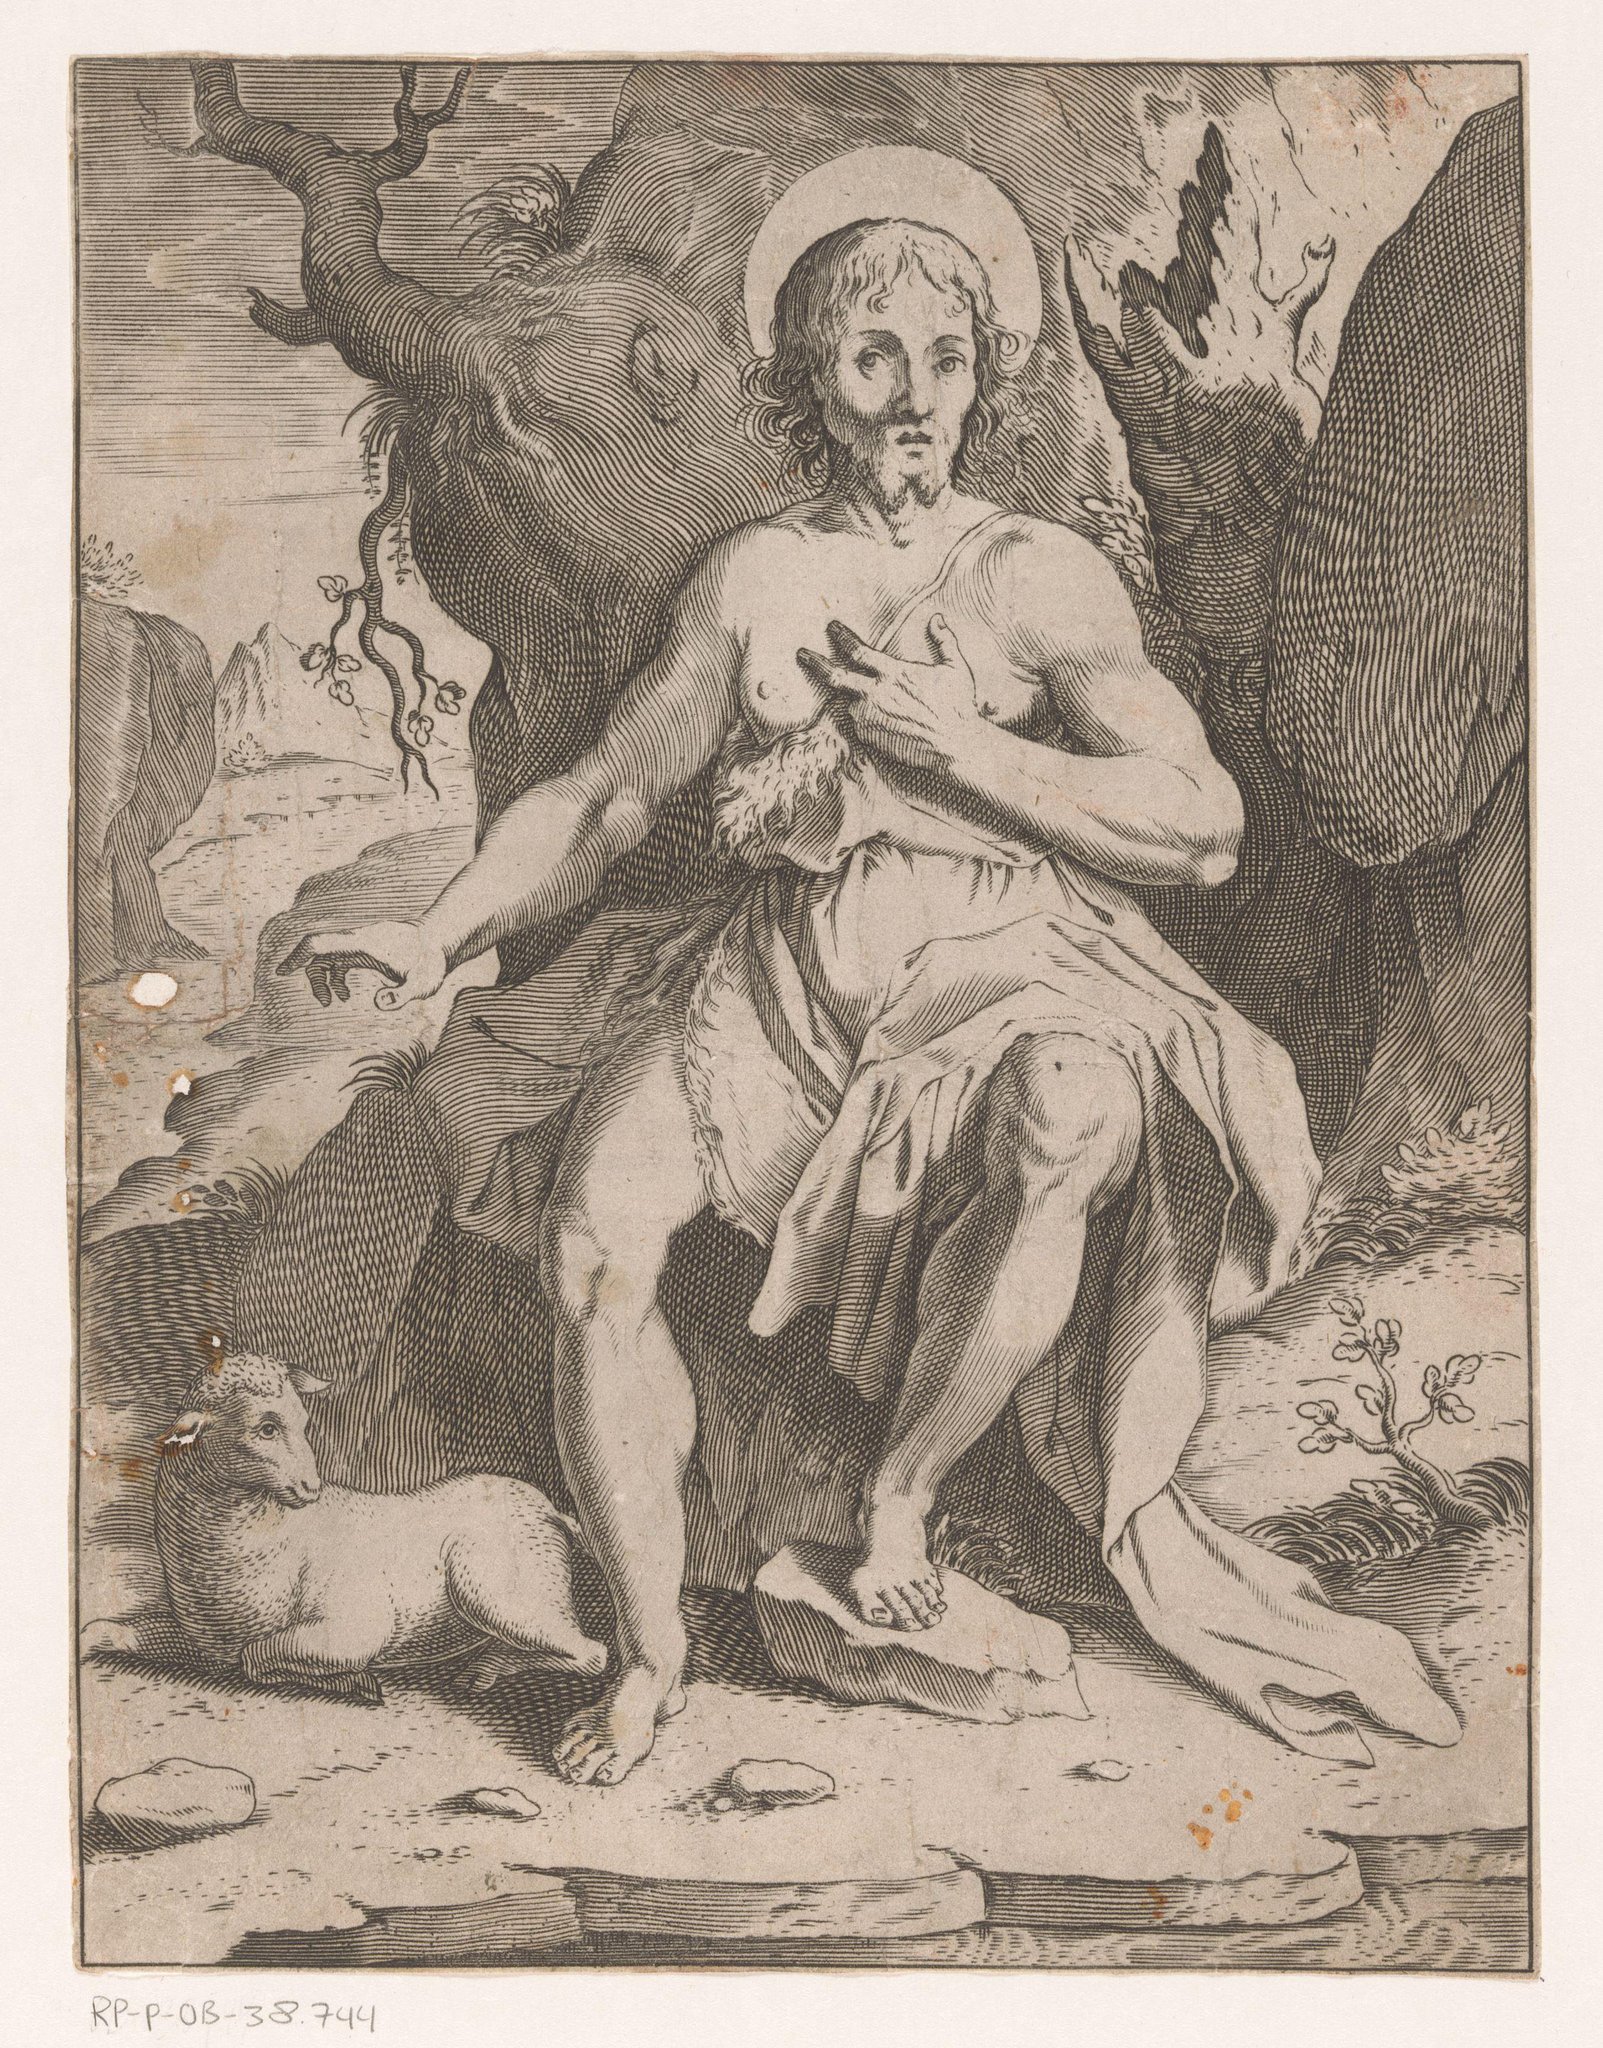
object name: print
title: Johannes de Doper met lam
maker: Anonymous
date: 1550-1649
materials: paper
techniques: engraving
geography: italy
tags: john the baptist; possible attributes: book, reed cross, baptismal cup, honeycomb, lamb, staff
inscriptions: collector's mark: Lugt 240